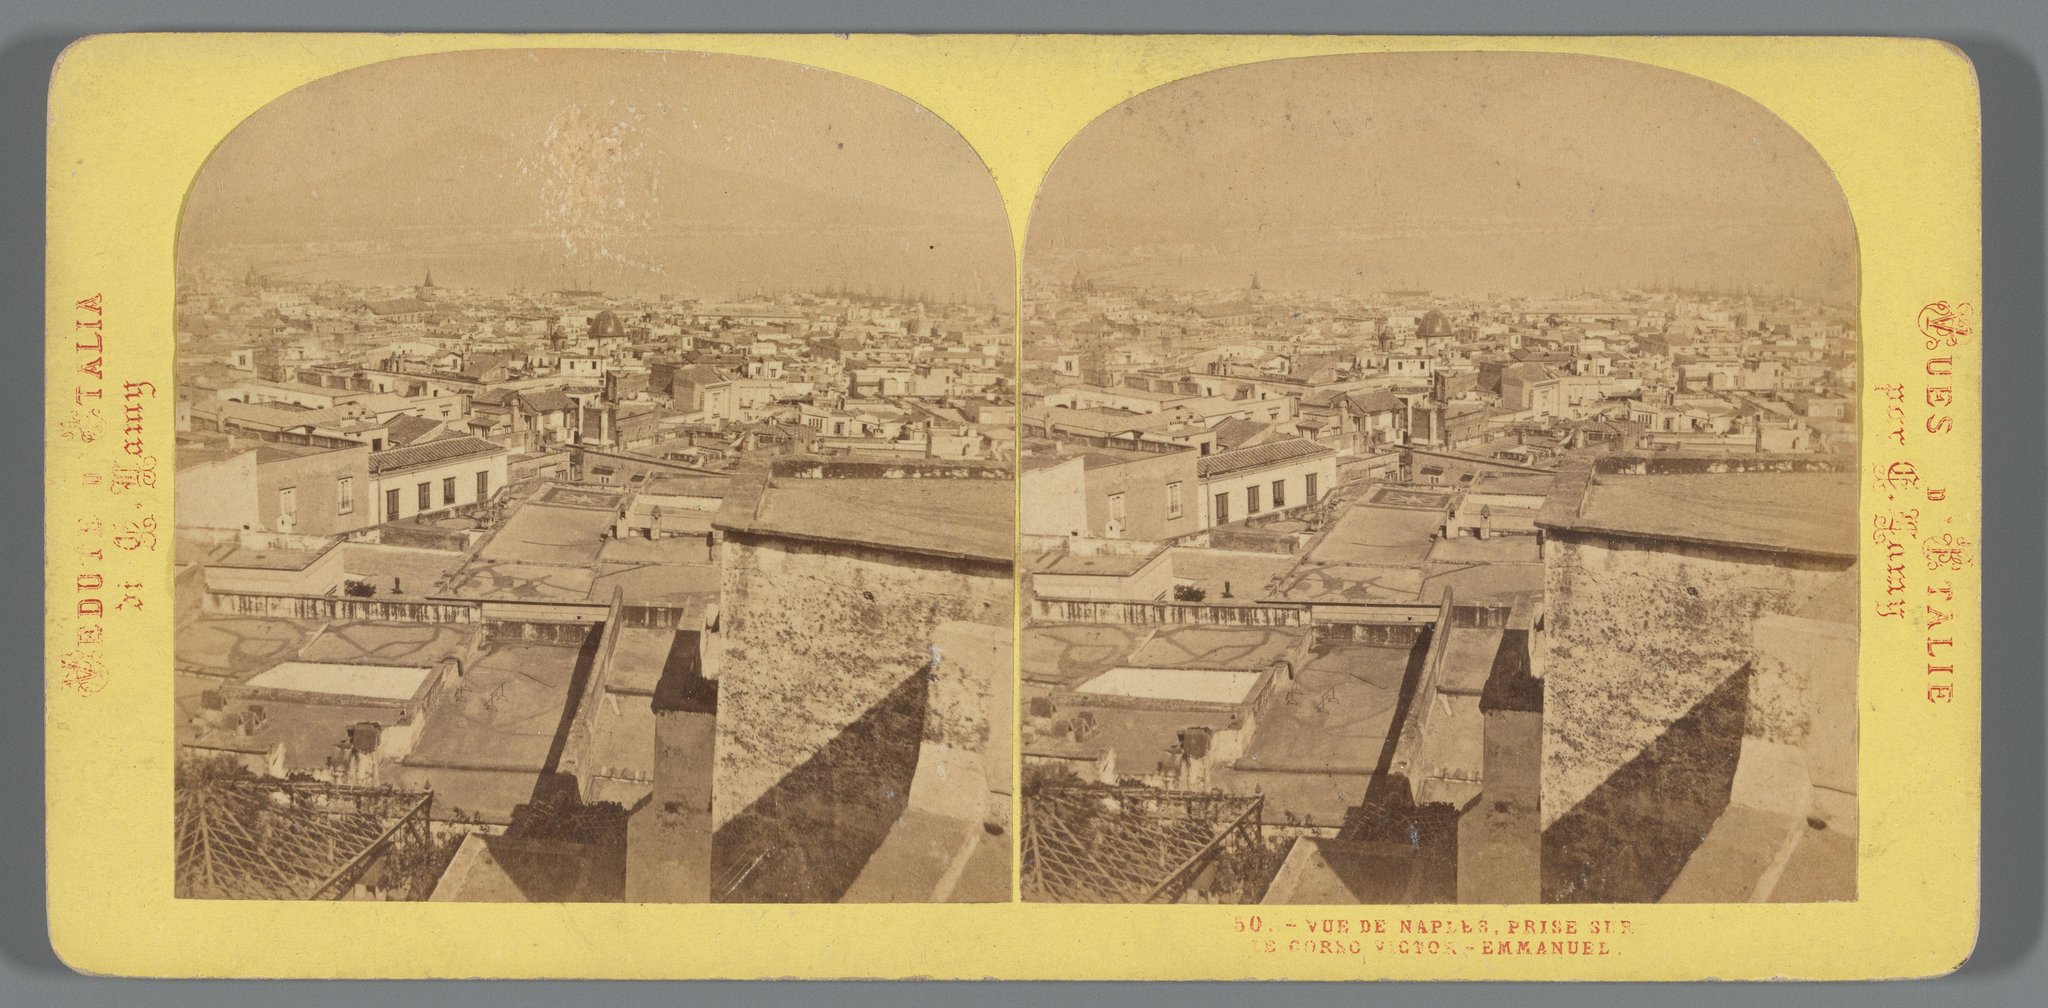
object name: stereograph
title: Gezicht op Napels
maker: ernest eléonor pierre lamy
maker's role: publisher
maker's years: 1828-1900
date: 1868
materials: cardboard, paper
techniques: albumen print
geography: paris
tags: city-view in general; 'veduta', naples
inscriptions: number: ‘50.’